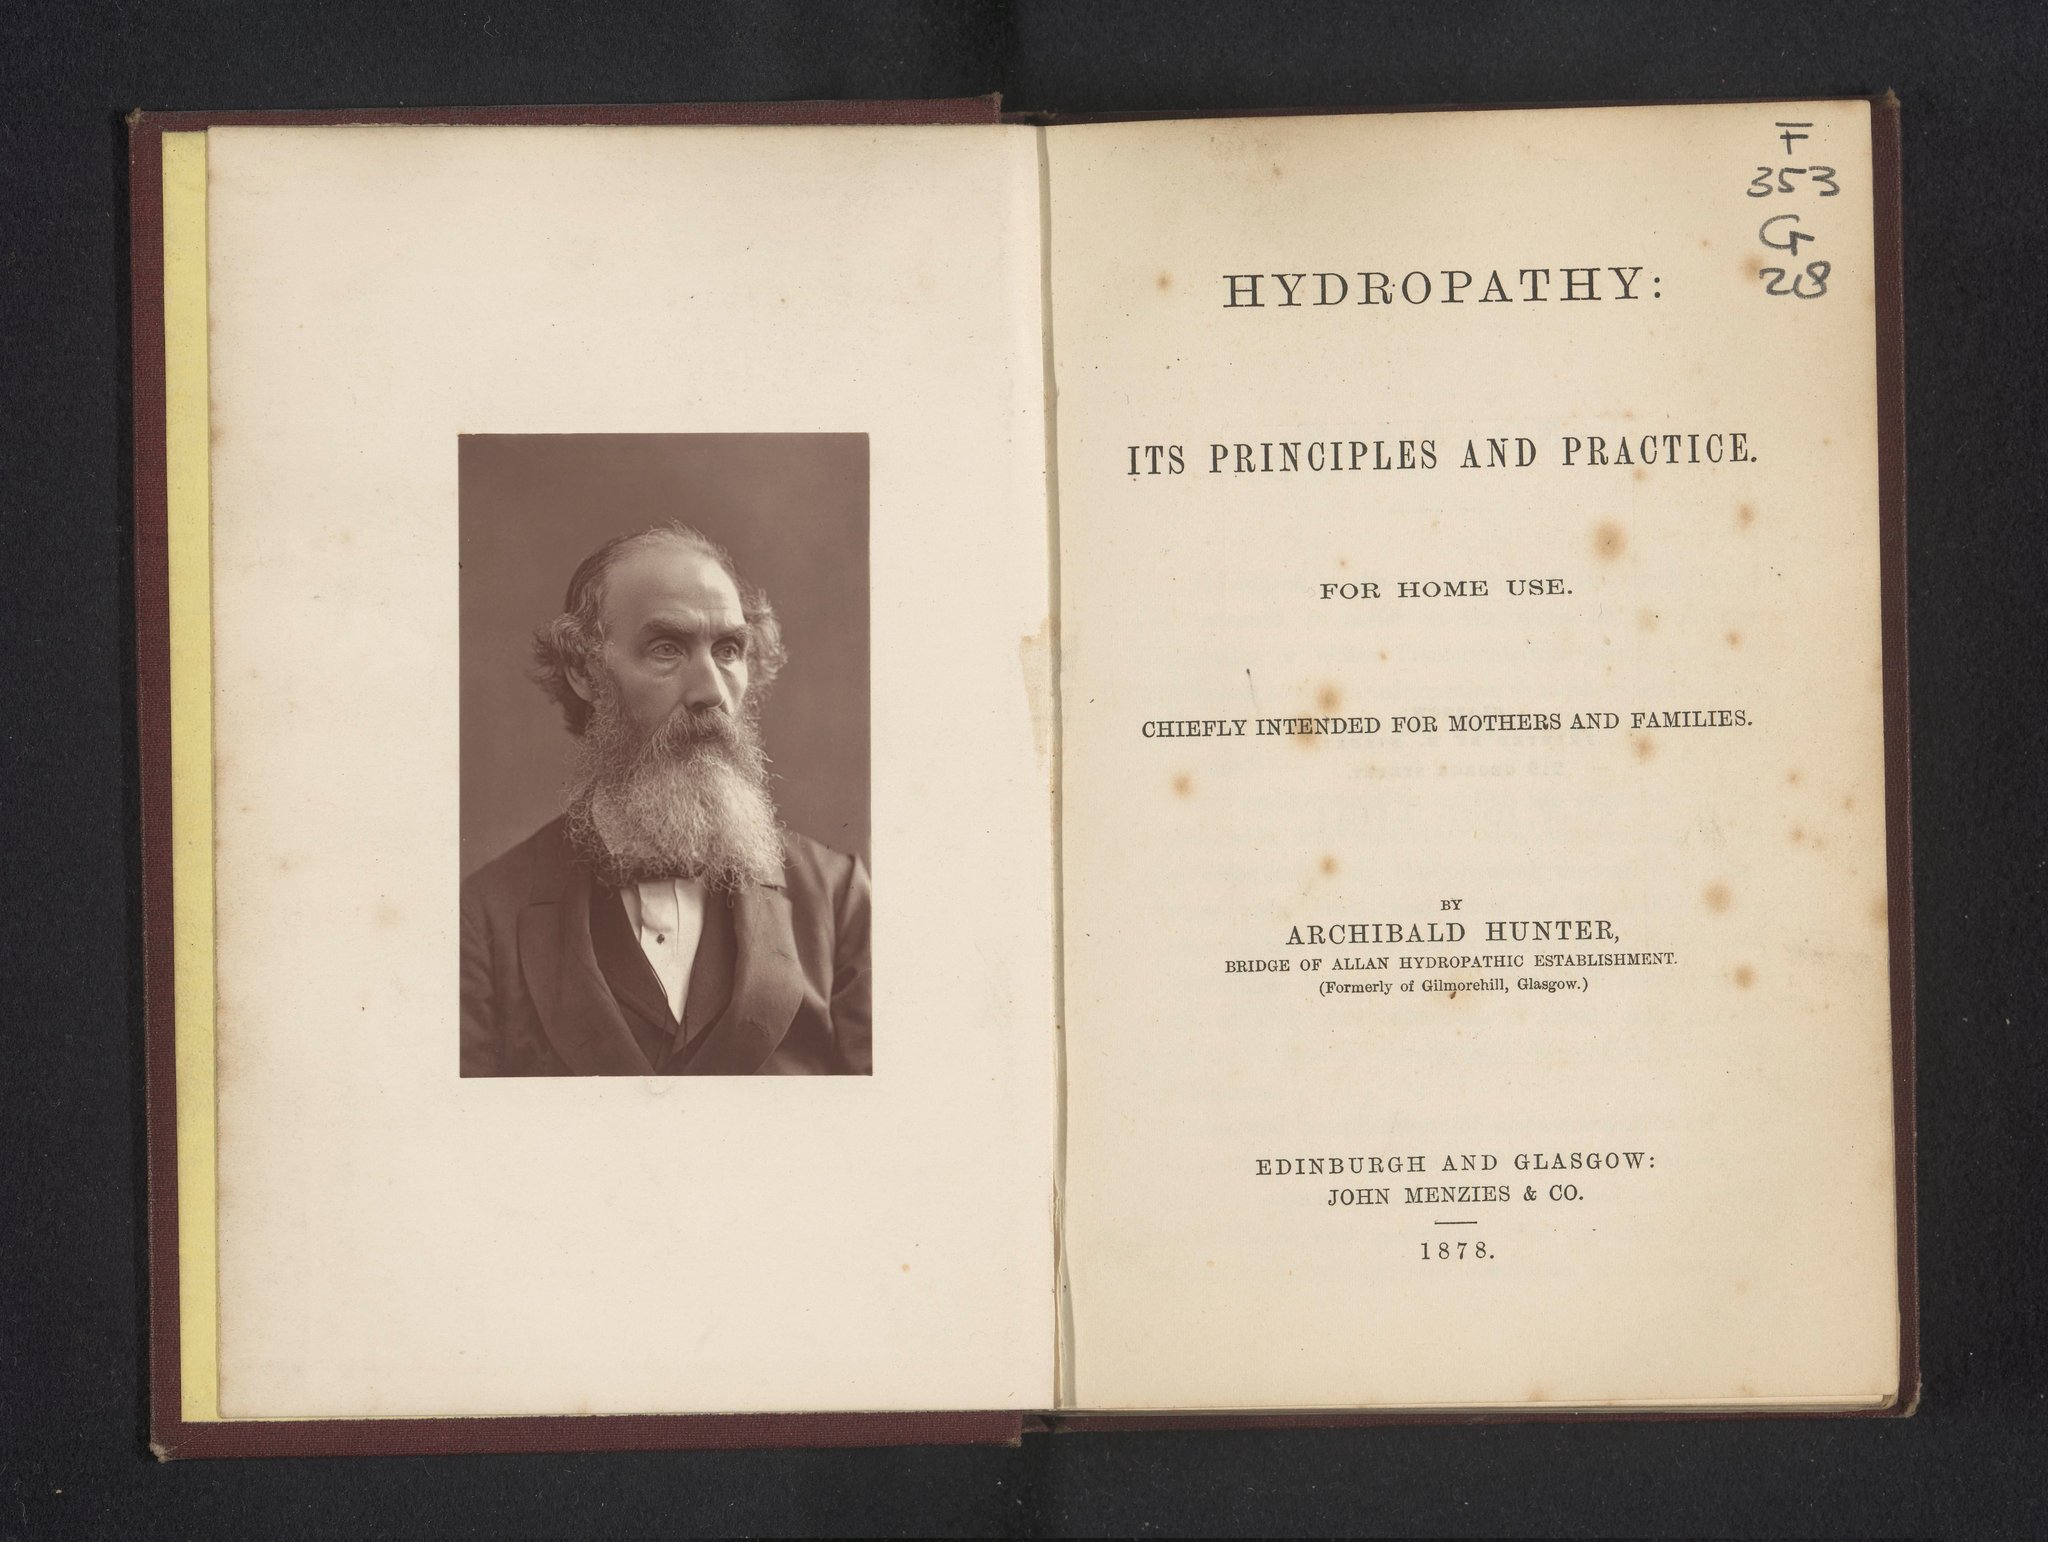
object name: photomechanical print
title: Portret van Archibald Hunter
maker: Anonymous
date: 1873-1878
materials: paper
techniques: woodburytype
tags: archibald hunter, portrait of a writer